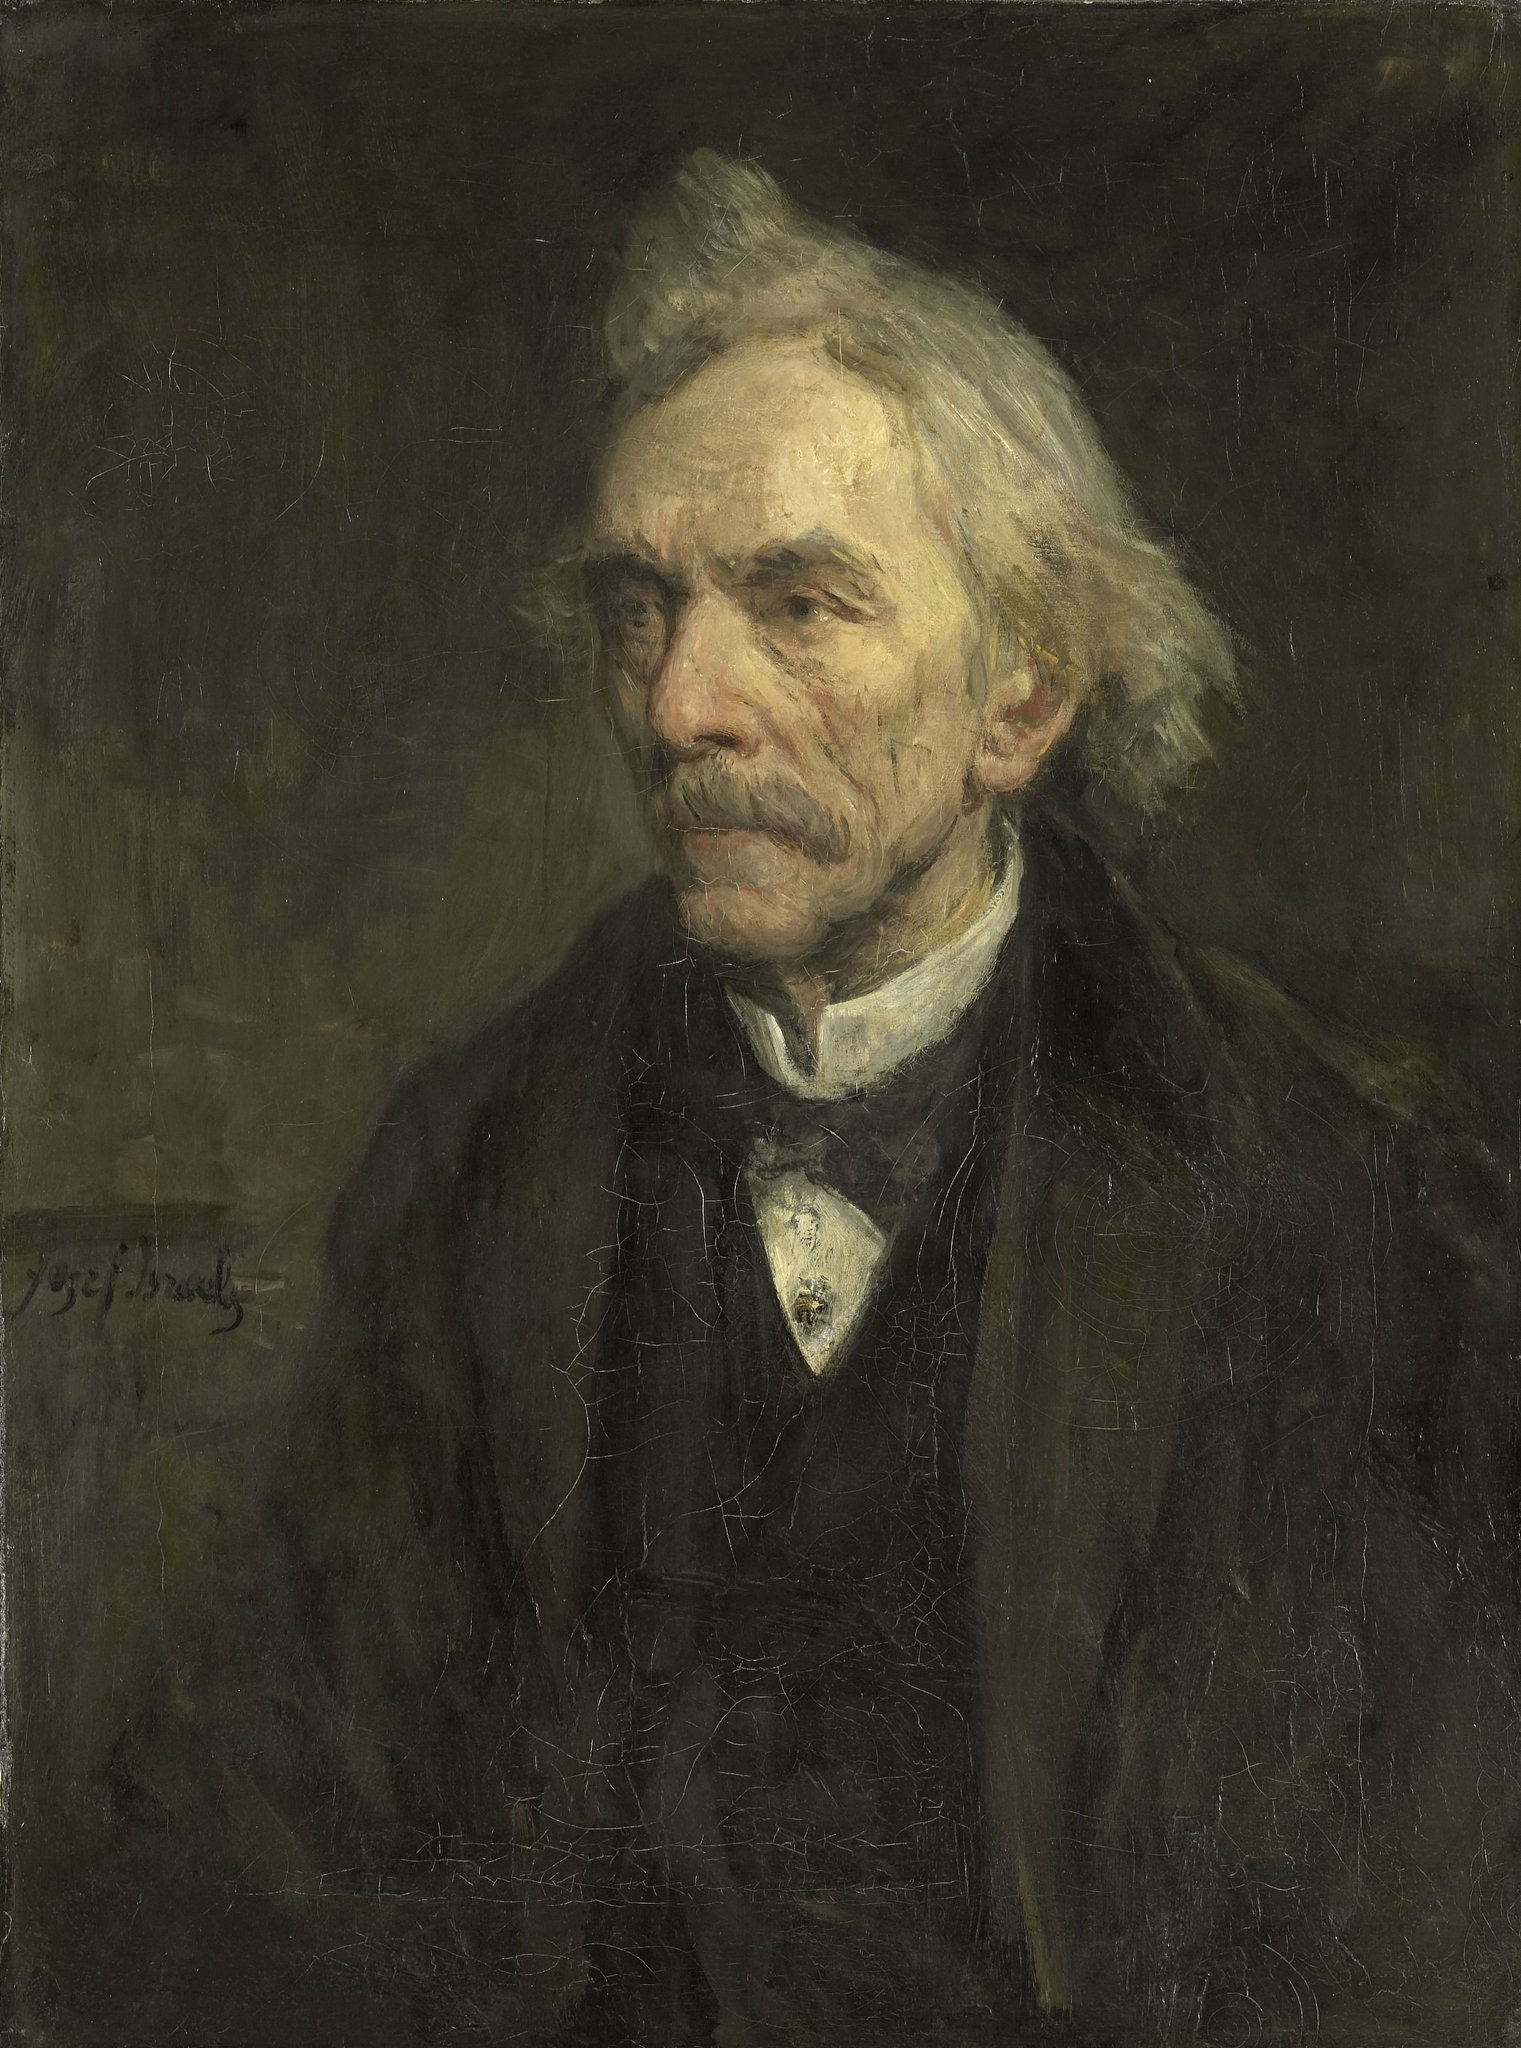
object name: painting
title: Louis Jacques Veltman (1817-1907). Actor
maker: jozef israëls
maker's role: draughtsman, painter, print maker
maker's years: 1824-1911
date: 1893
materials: canvas, oil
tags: historical persons, portrait of actor, actress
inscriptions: signature: ‘Jozef Israels’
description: Portret van Louis Jacques Veltman, toneelspeler. Buste, naar links.